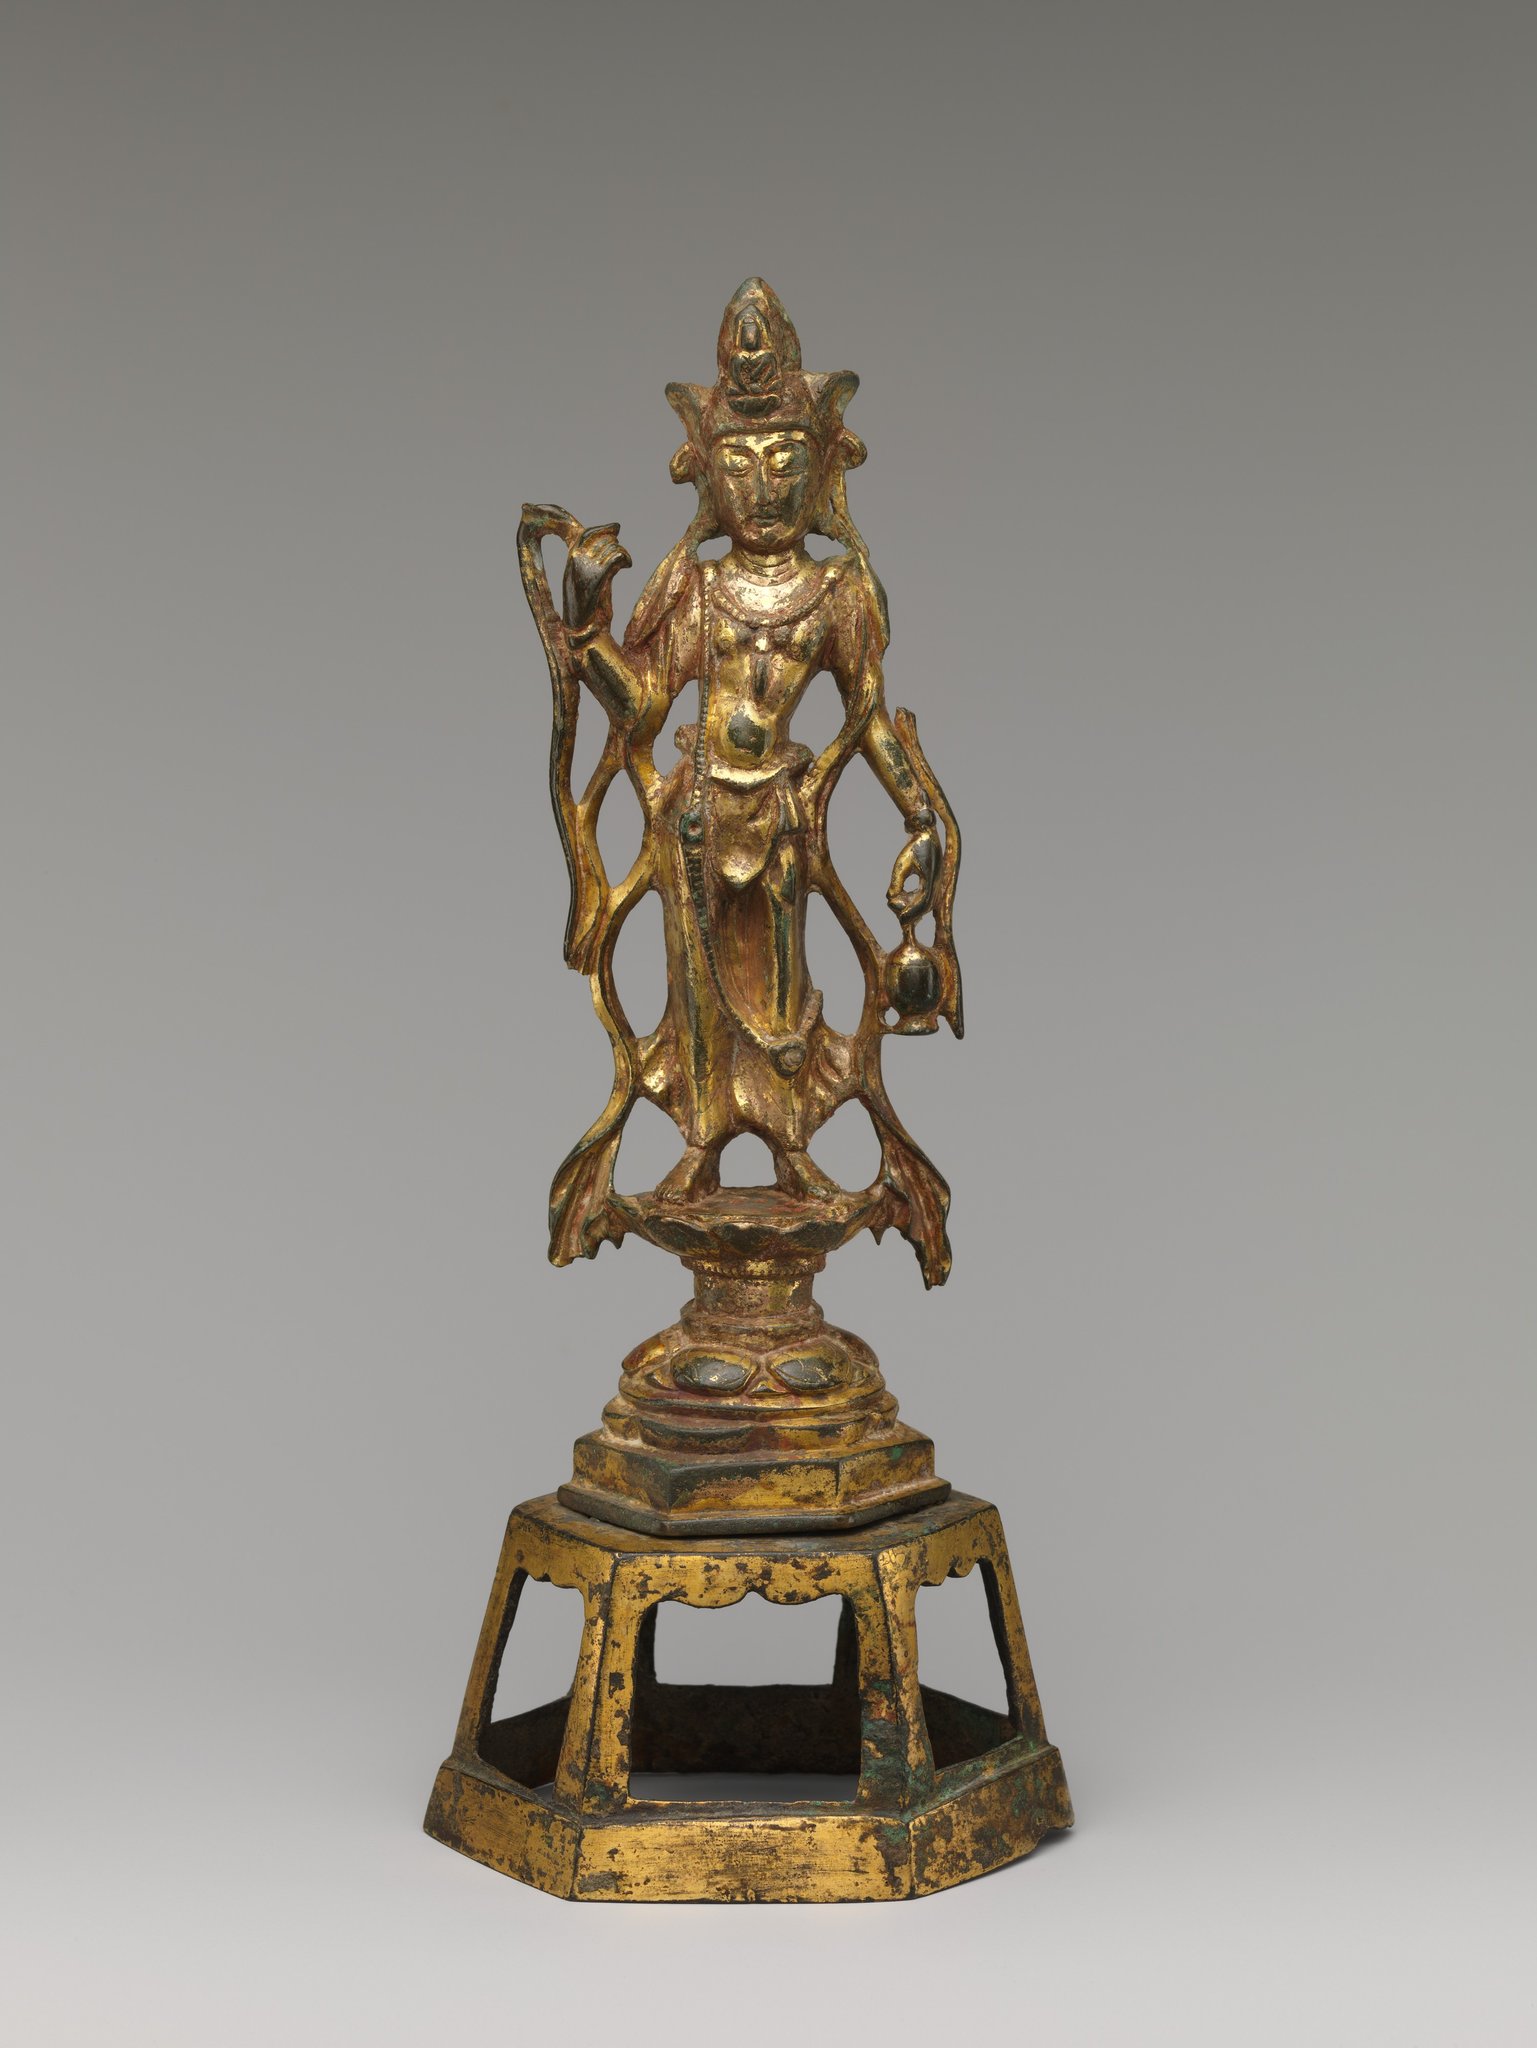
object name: figure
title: Bodhisattva Avalokiteshvara (Guanyin)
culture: chinese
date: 667-733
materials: gilt bronze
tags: buddhism,avalokiteshvara,bodhisattvas